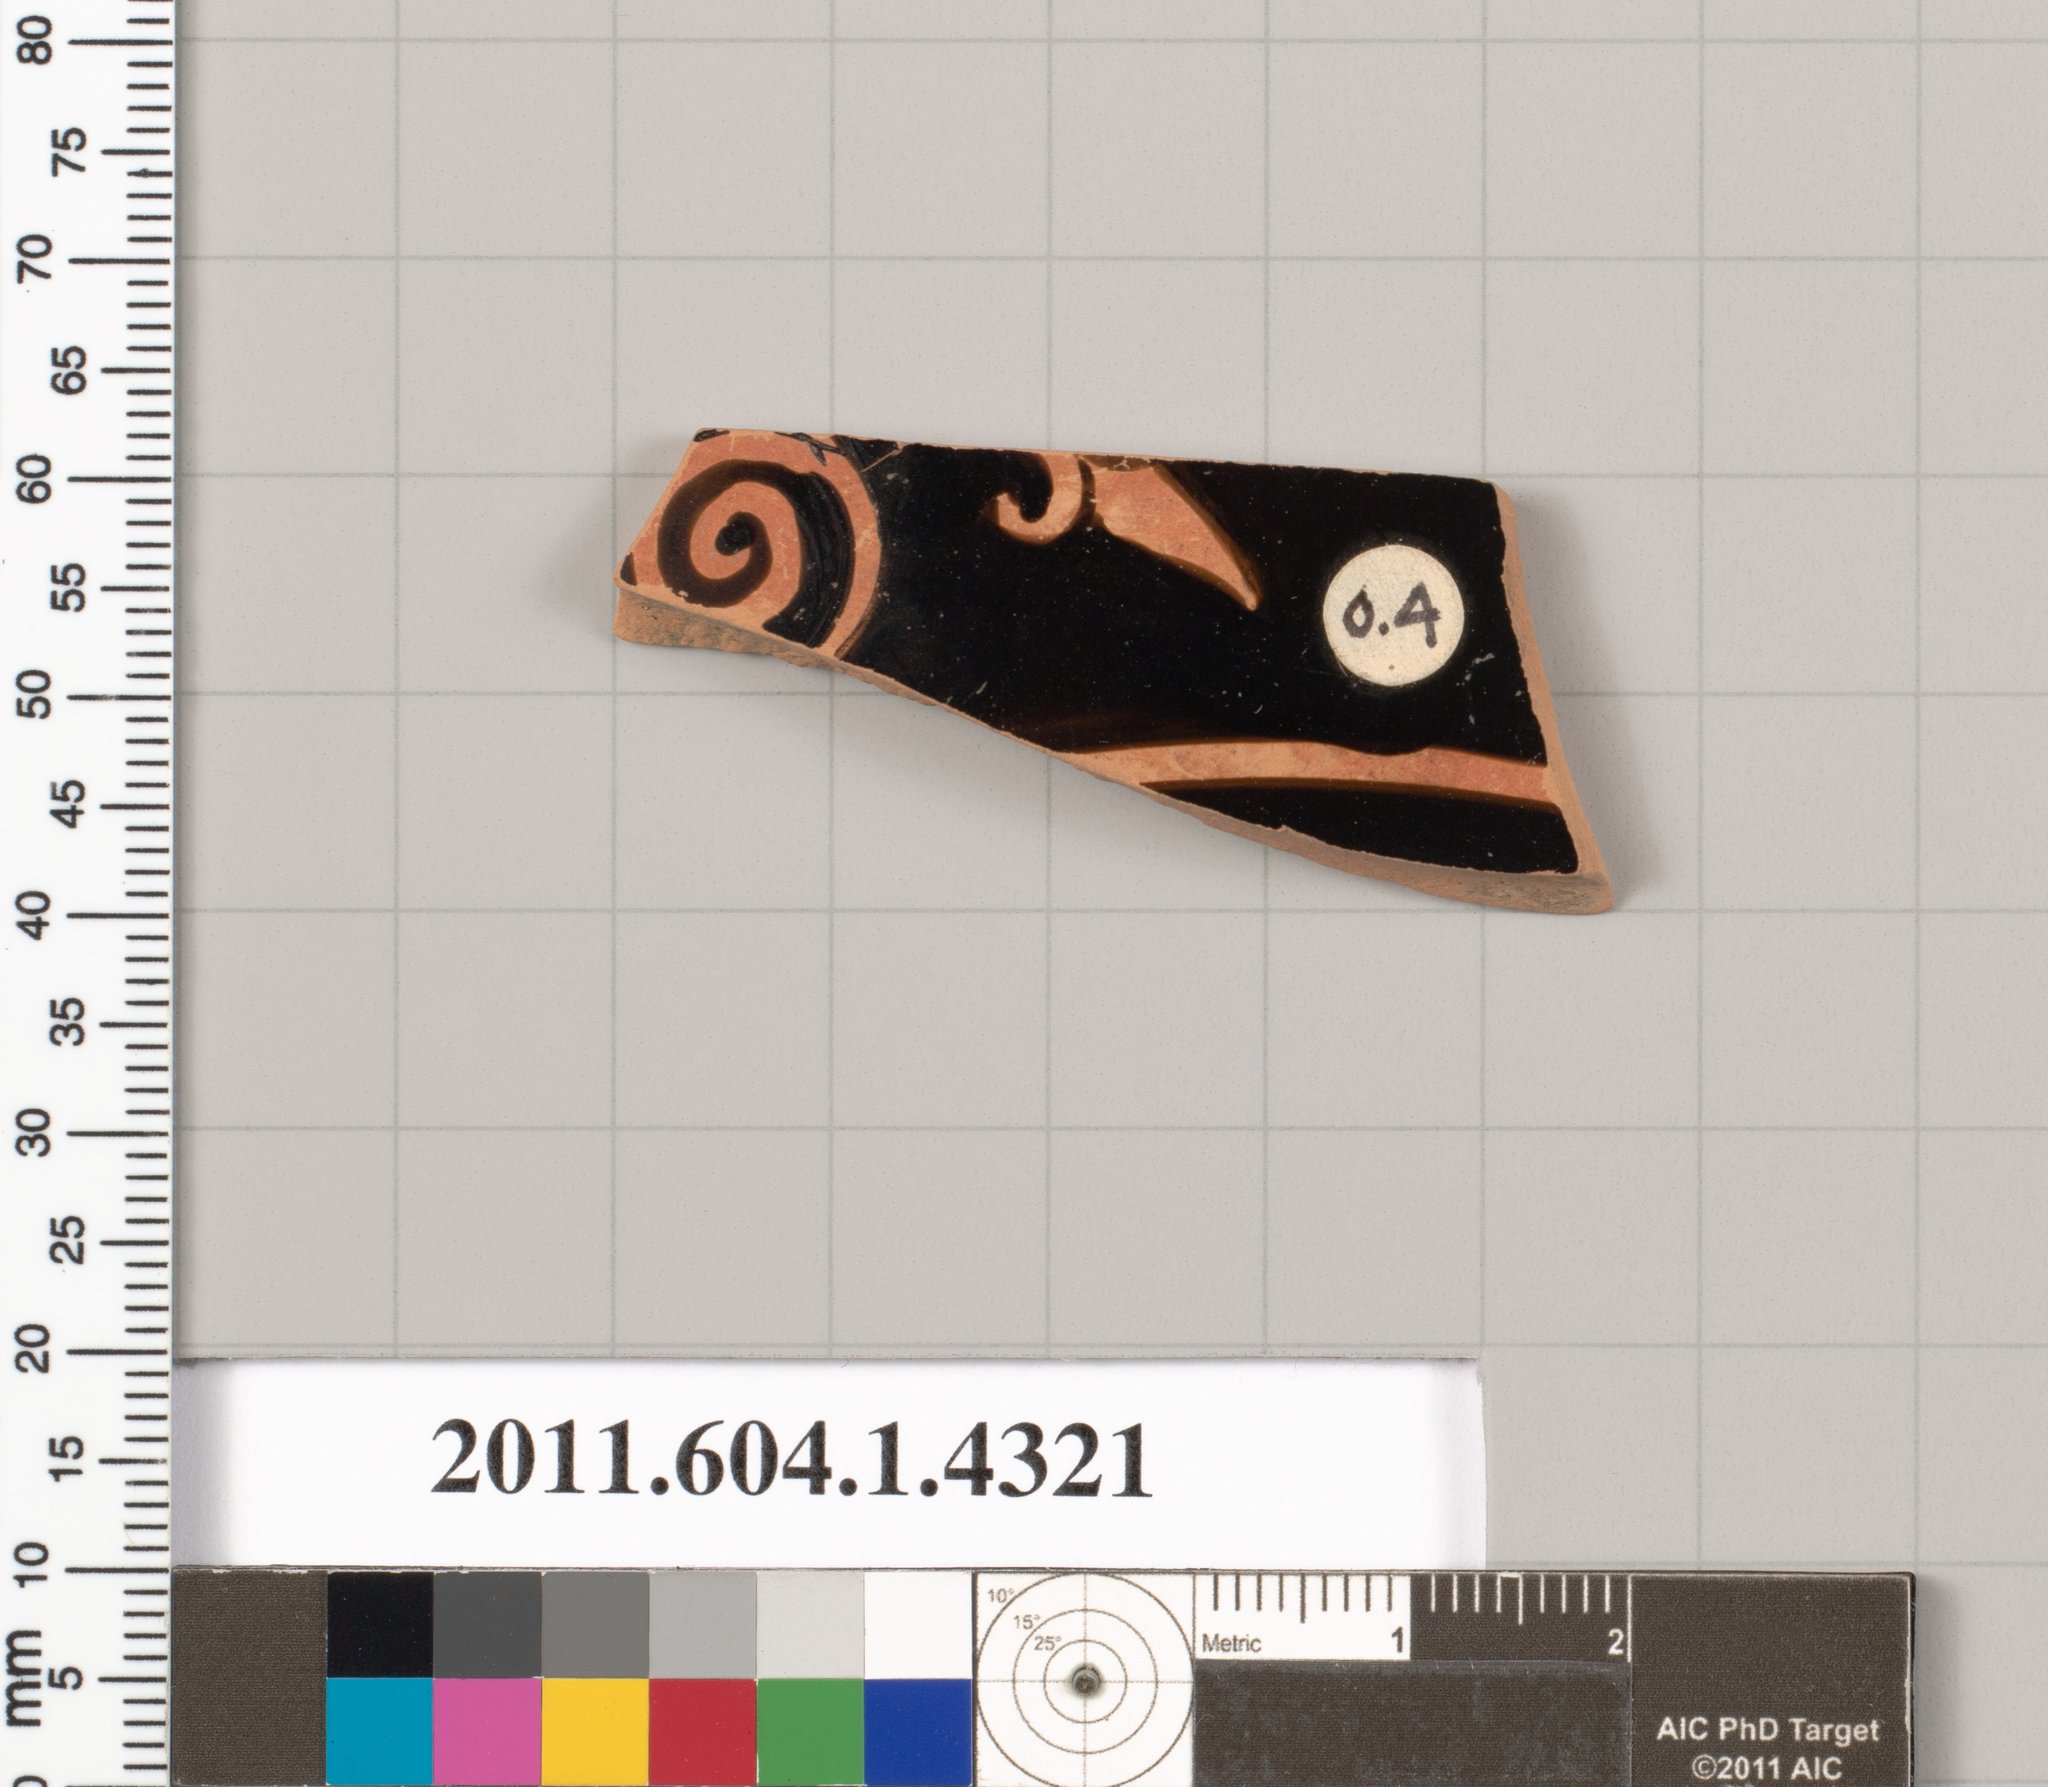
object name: kylix fragment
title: Terracotta fragment of a kylix (drinking cup)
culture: greek, attic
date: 500-476 BCE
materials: terracotta